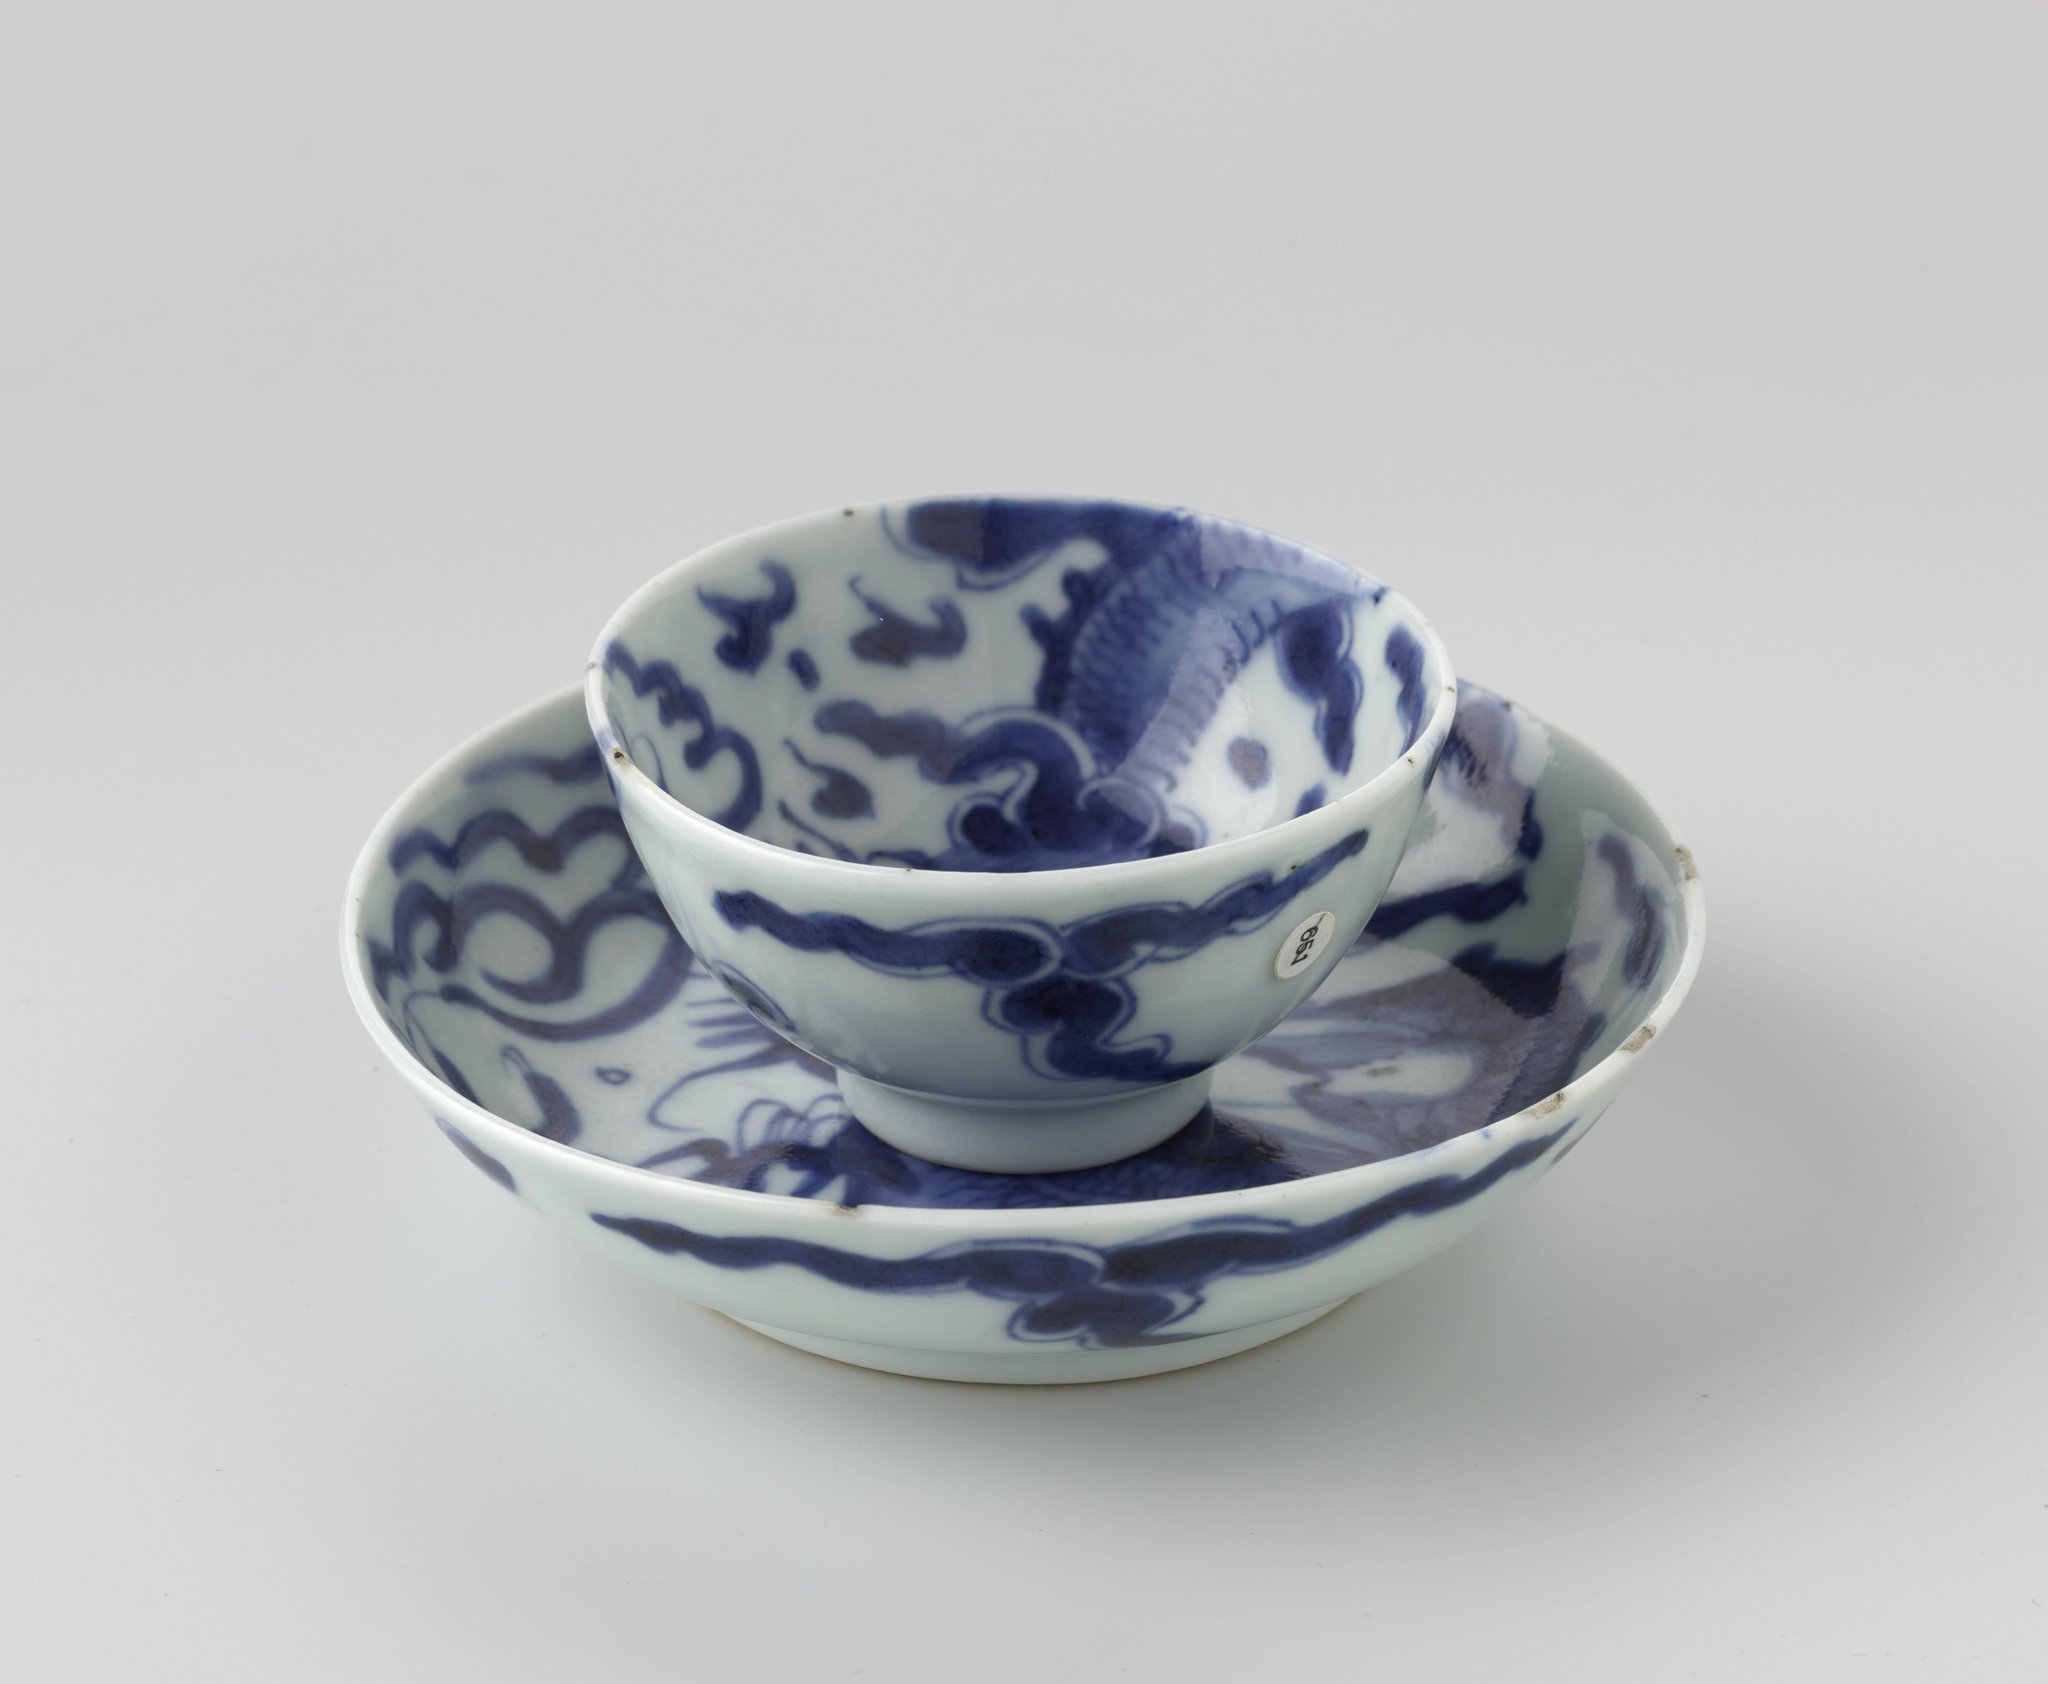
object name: kop en schotel, kop en schotel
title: Cup and saucer with a pearl chasing dragon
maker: Anonymous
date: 1750-1774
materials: cobalt, glaze, paint, porcelain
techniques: firing, turning, vitrification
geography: china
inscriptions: mark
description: Kop en schotel van porselein met iets spreidende wand, beschilderd in onderglazuur blauw. Op de binnen- en buitenzijde een doorlopende vierklauwige draak een parel najagend, de staart aan de buitenzijde en de kop aan de binnenzijde; de draak is omgeven door wolkmotieven. Gemerkt op de onderzijde met een zegelmerk in een dubbele cirkel. Een chip in de rand van de schotel. Blauw-wit.